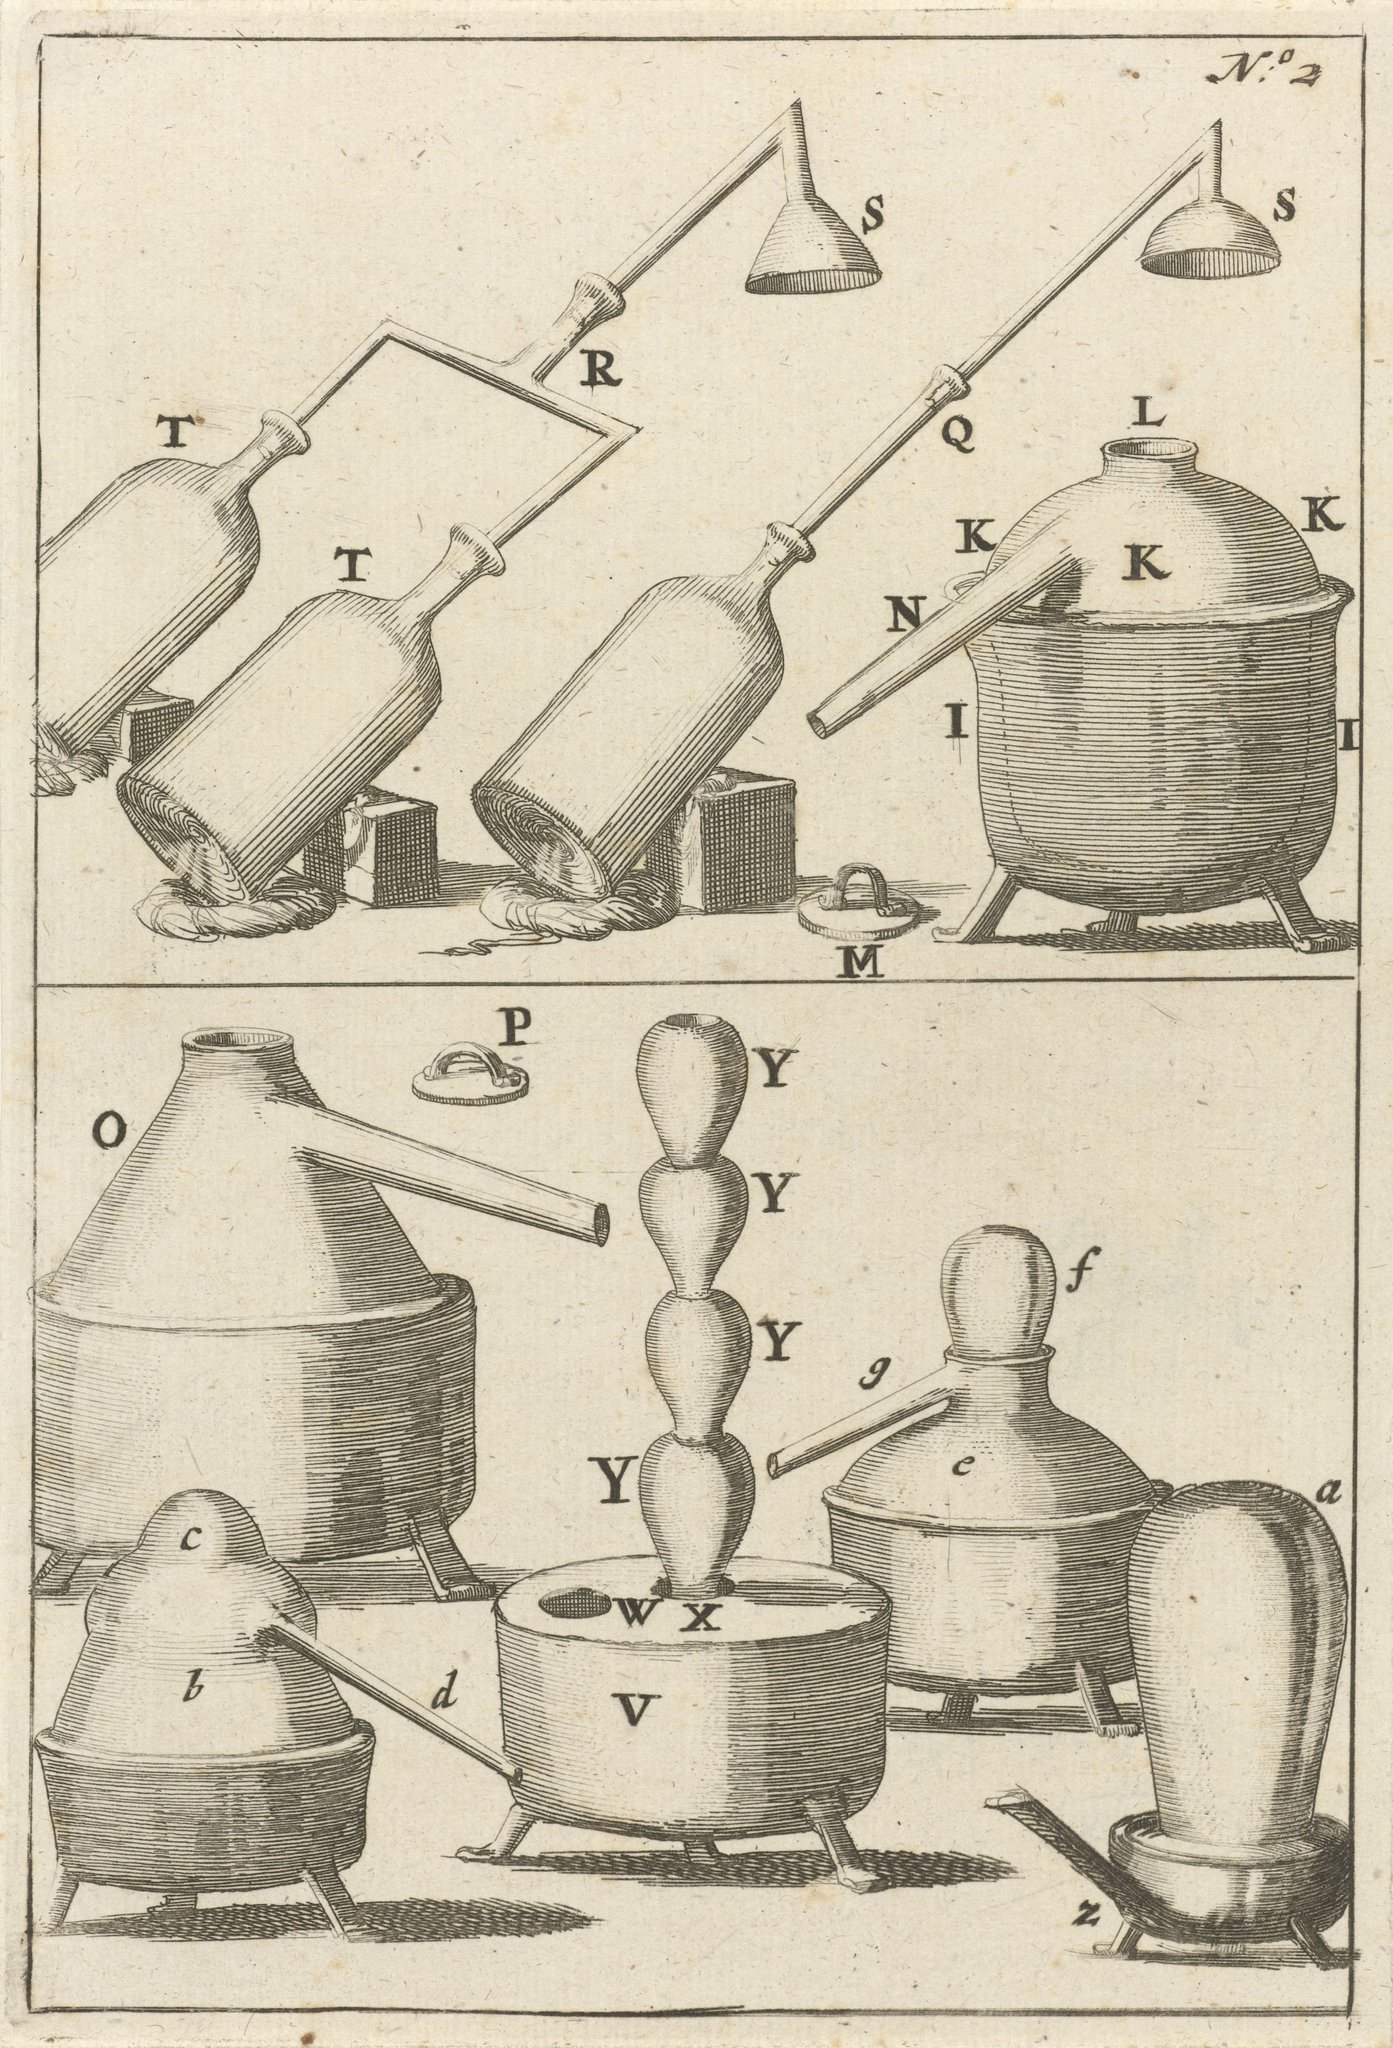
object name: print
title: Verschillende afbeeldingen van retorten en distilleertoestellen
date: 1689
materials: paper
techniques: etching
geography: amsterdam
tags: laboratory (+ tools, instruments; laboratory equipment ~ scientific research), pharmacy, pharmaceutics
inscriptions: collector's mark: Lugt 2228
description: Illustratie uit: Bontekoe, Cornelis. Alle de philosophische, medicinale en chymische werken, 4 delen. Amsterdam: Jan Claesz ten Hoorn, 1689, dl. IV, p. 383.